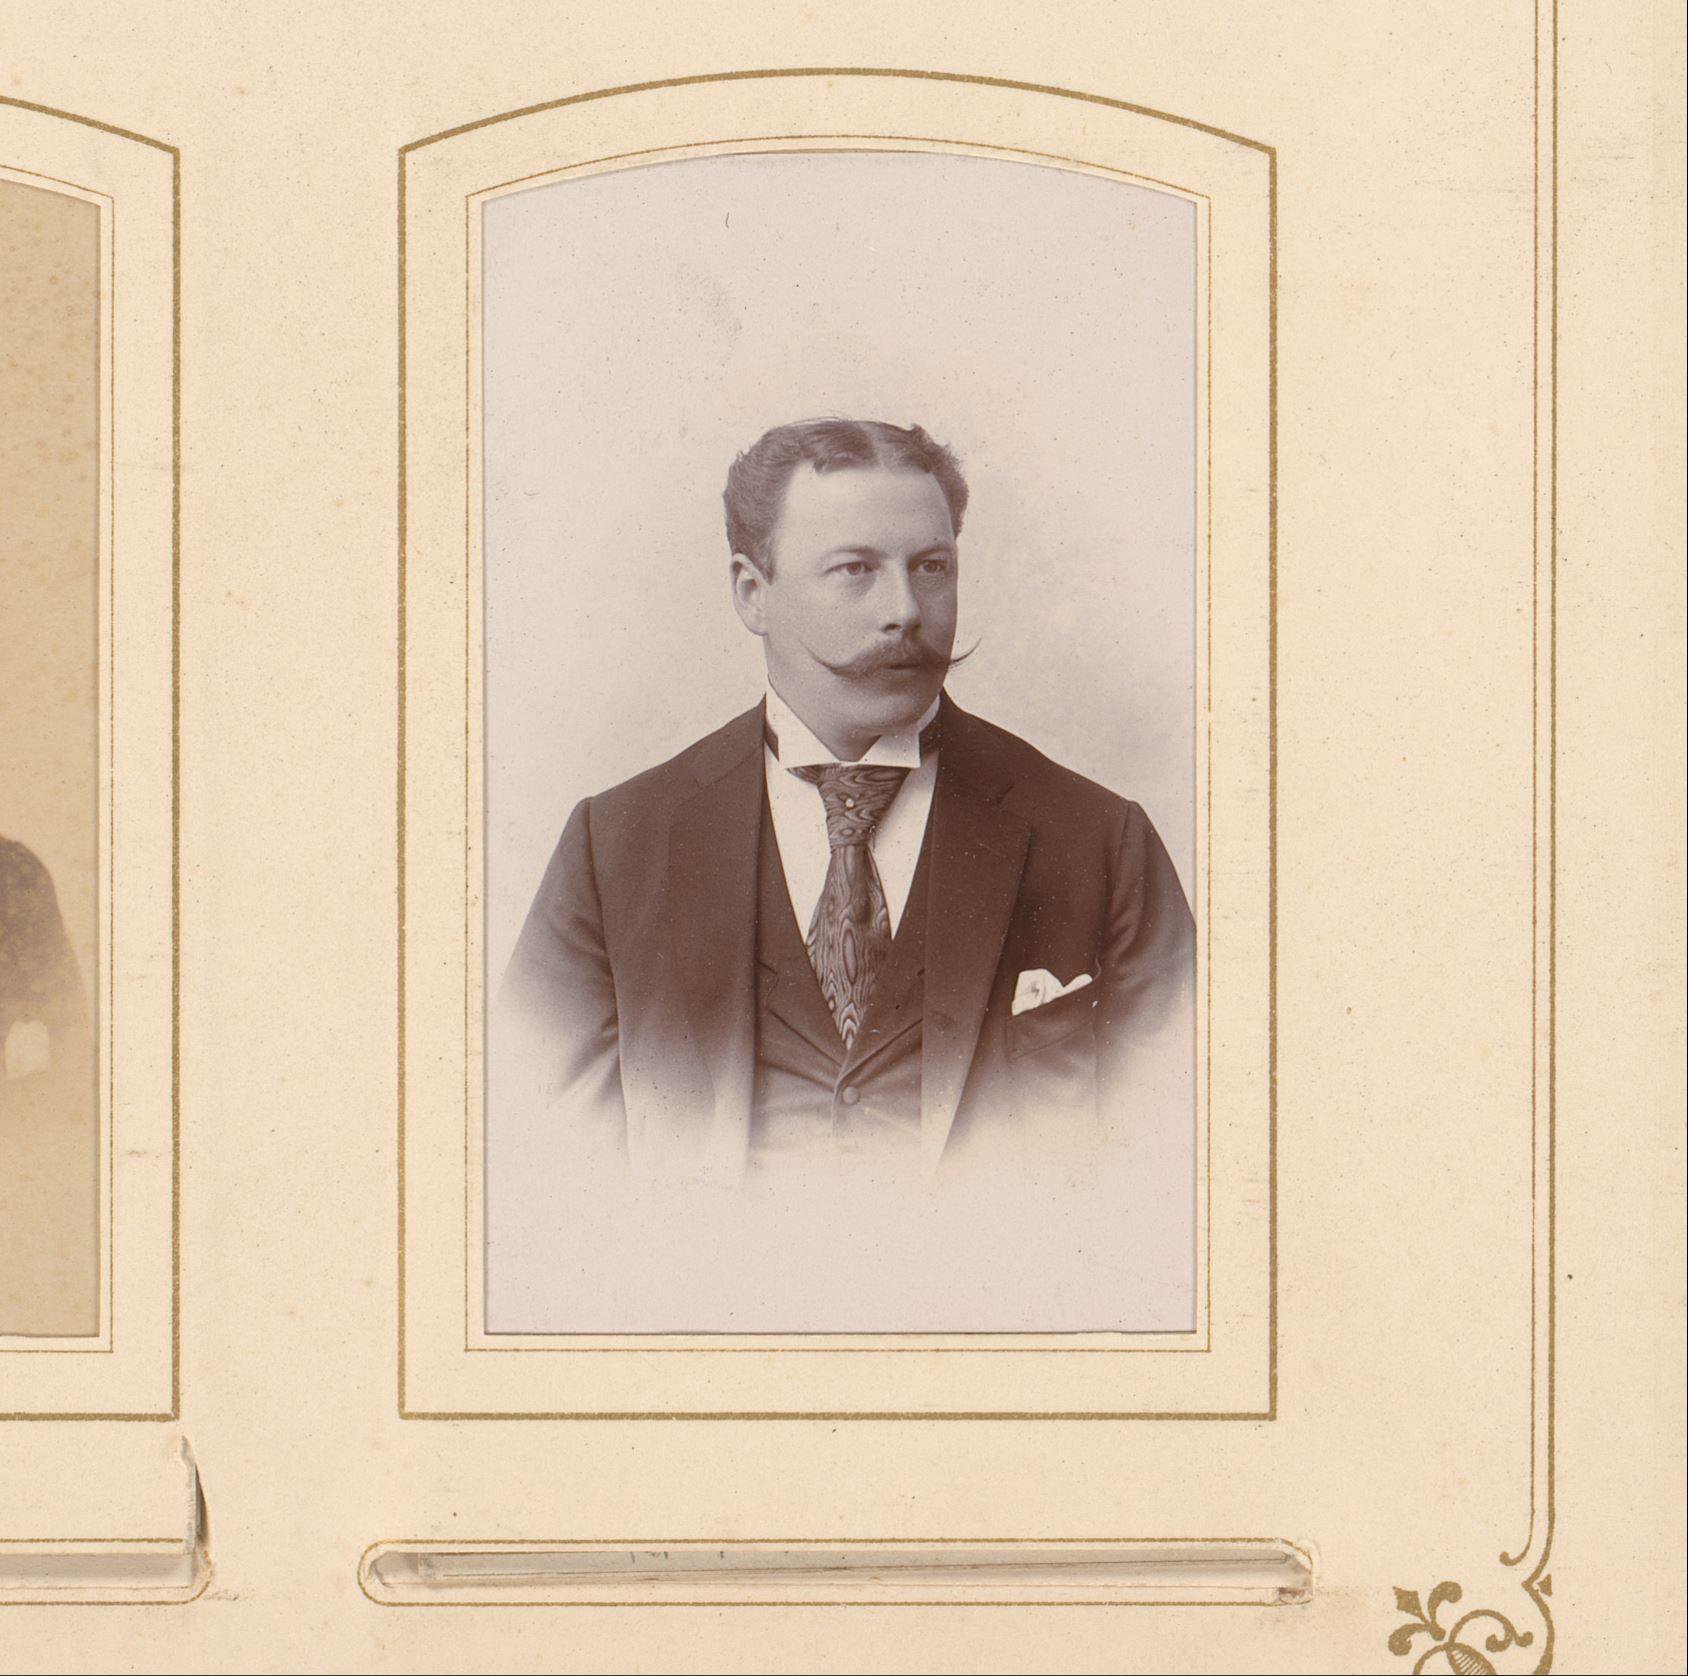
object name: carte de visite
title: Portret van een man met snor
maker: edmund risse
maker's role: fotograaf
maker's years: 1835-1891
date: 1895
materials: cardboard, photographic support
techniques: collodion silver print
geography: bochum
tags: moustache, historical persons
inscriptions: annotation: ‘1895. Herbst’, inscription: ‘(...) Edmund Risse/ (...) BOCHUM/ Friedrich-Str. 35./ Norderney/ Mittel-Str. 1 u. Kaiser-Str./ Die Platte wird für Nachbestellungen aufbewahrt./ Vergrösserungen bis Lebensgrösse’